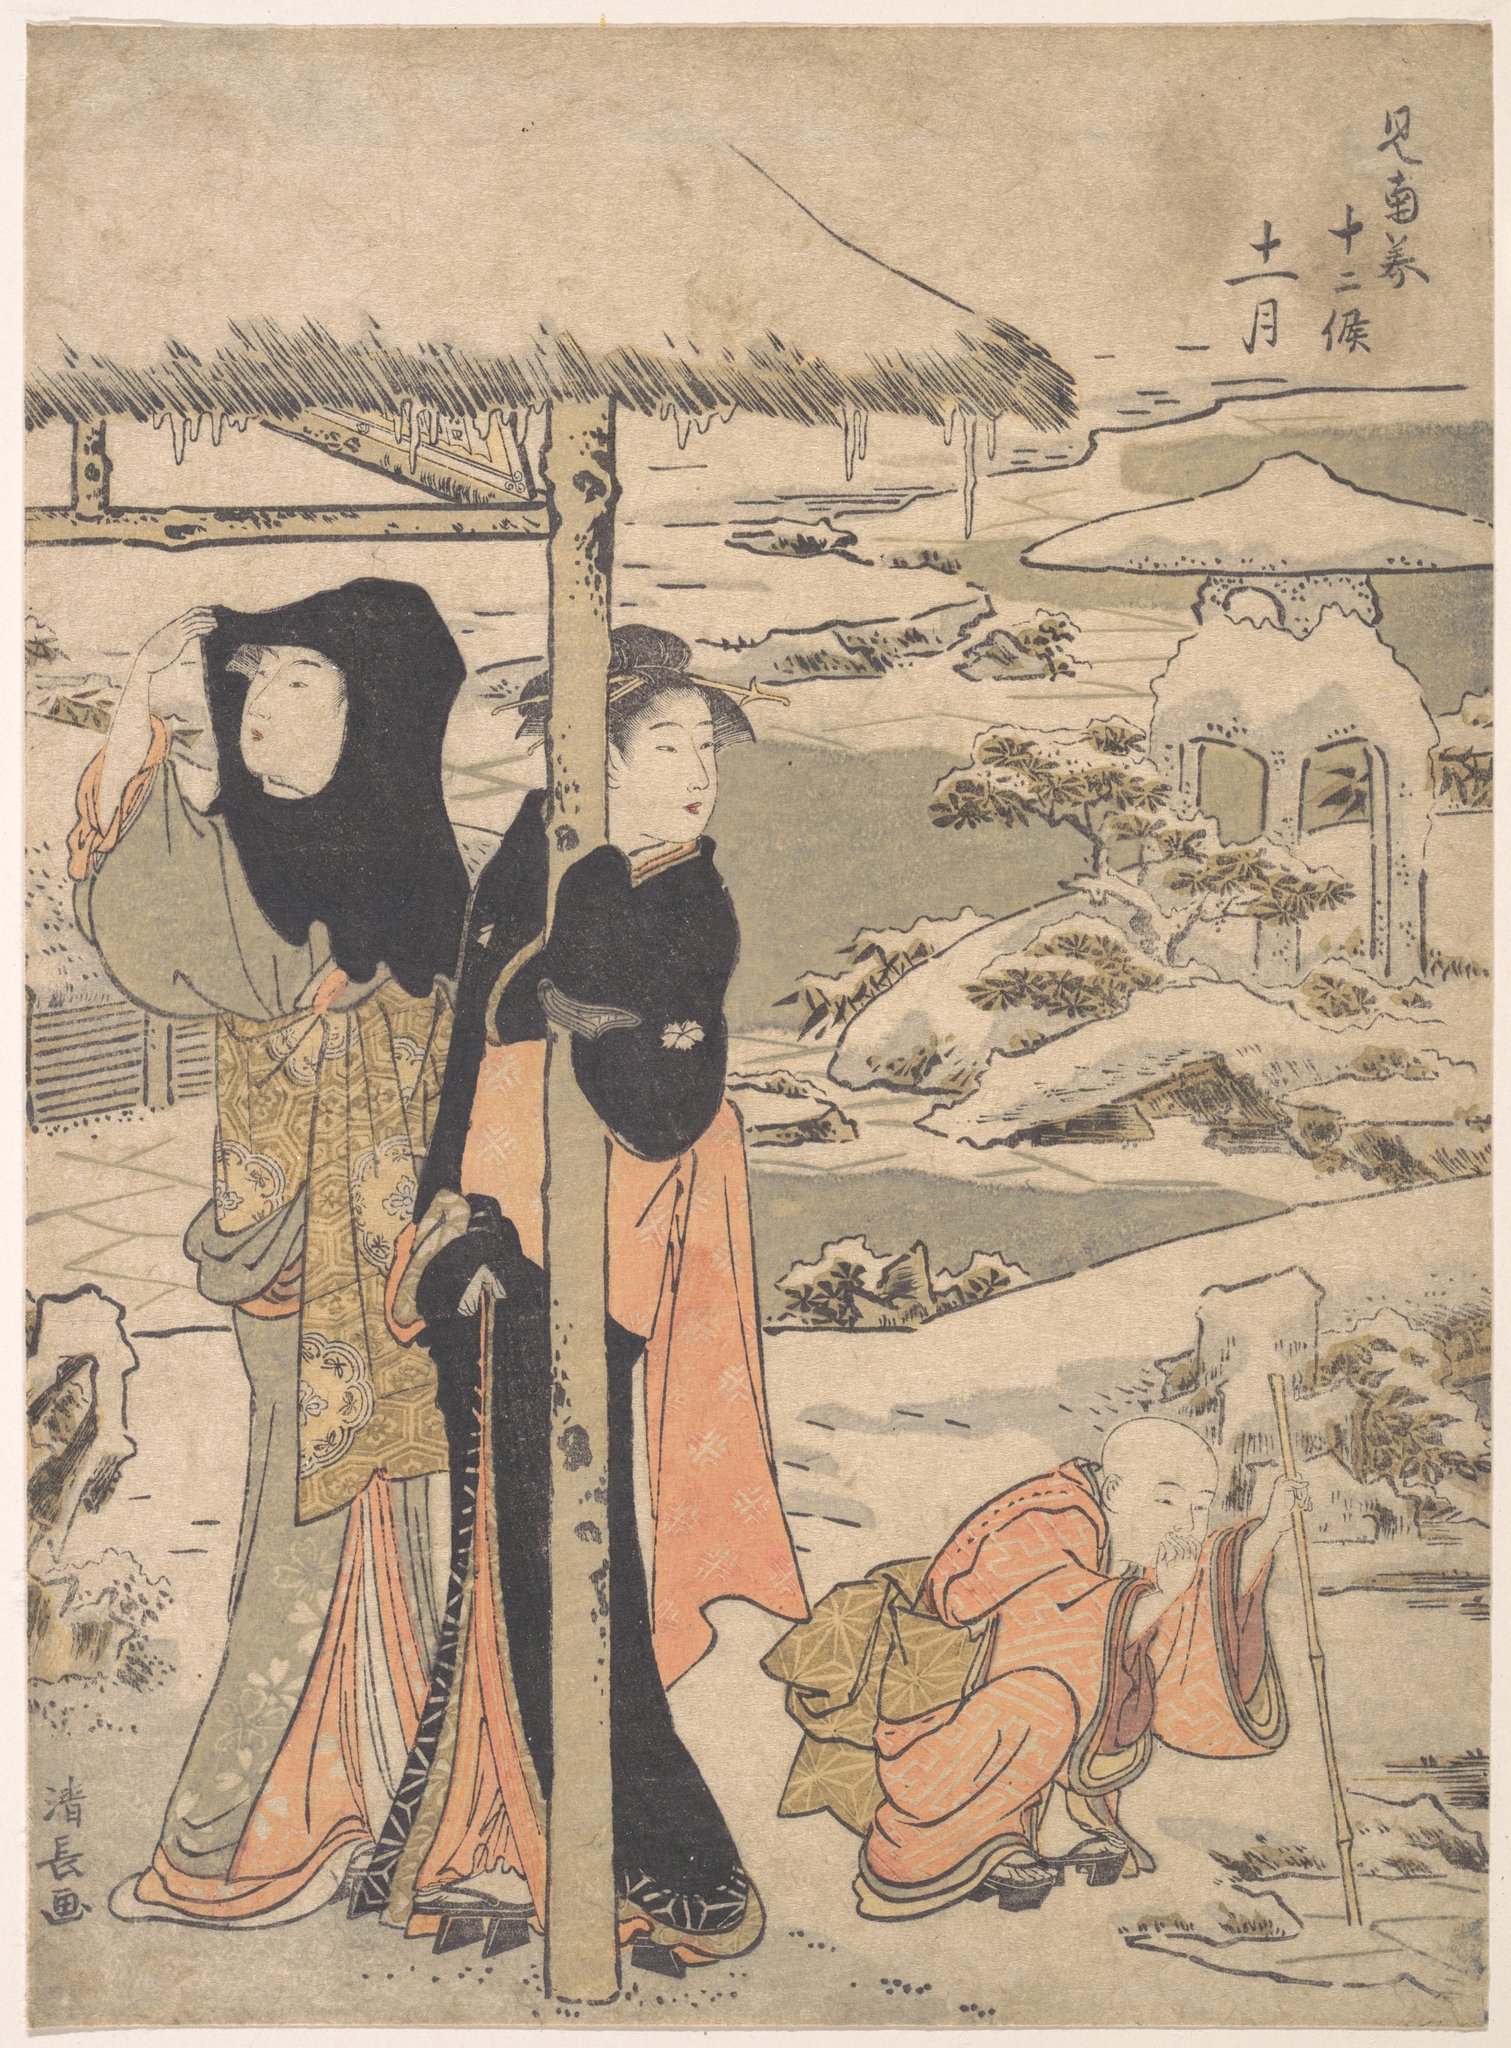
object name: print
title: A Day in Winter; Two Ladies and a Child in a Garden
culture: japanese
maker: torii kiyonaga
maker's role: artist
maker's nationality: japanese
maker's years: 1752-1815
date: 1742-1815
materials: ink, paper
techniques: woodblock print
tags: gardens,boys,women,winter